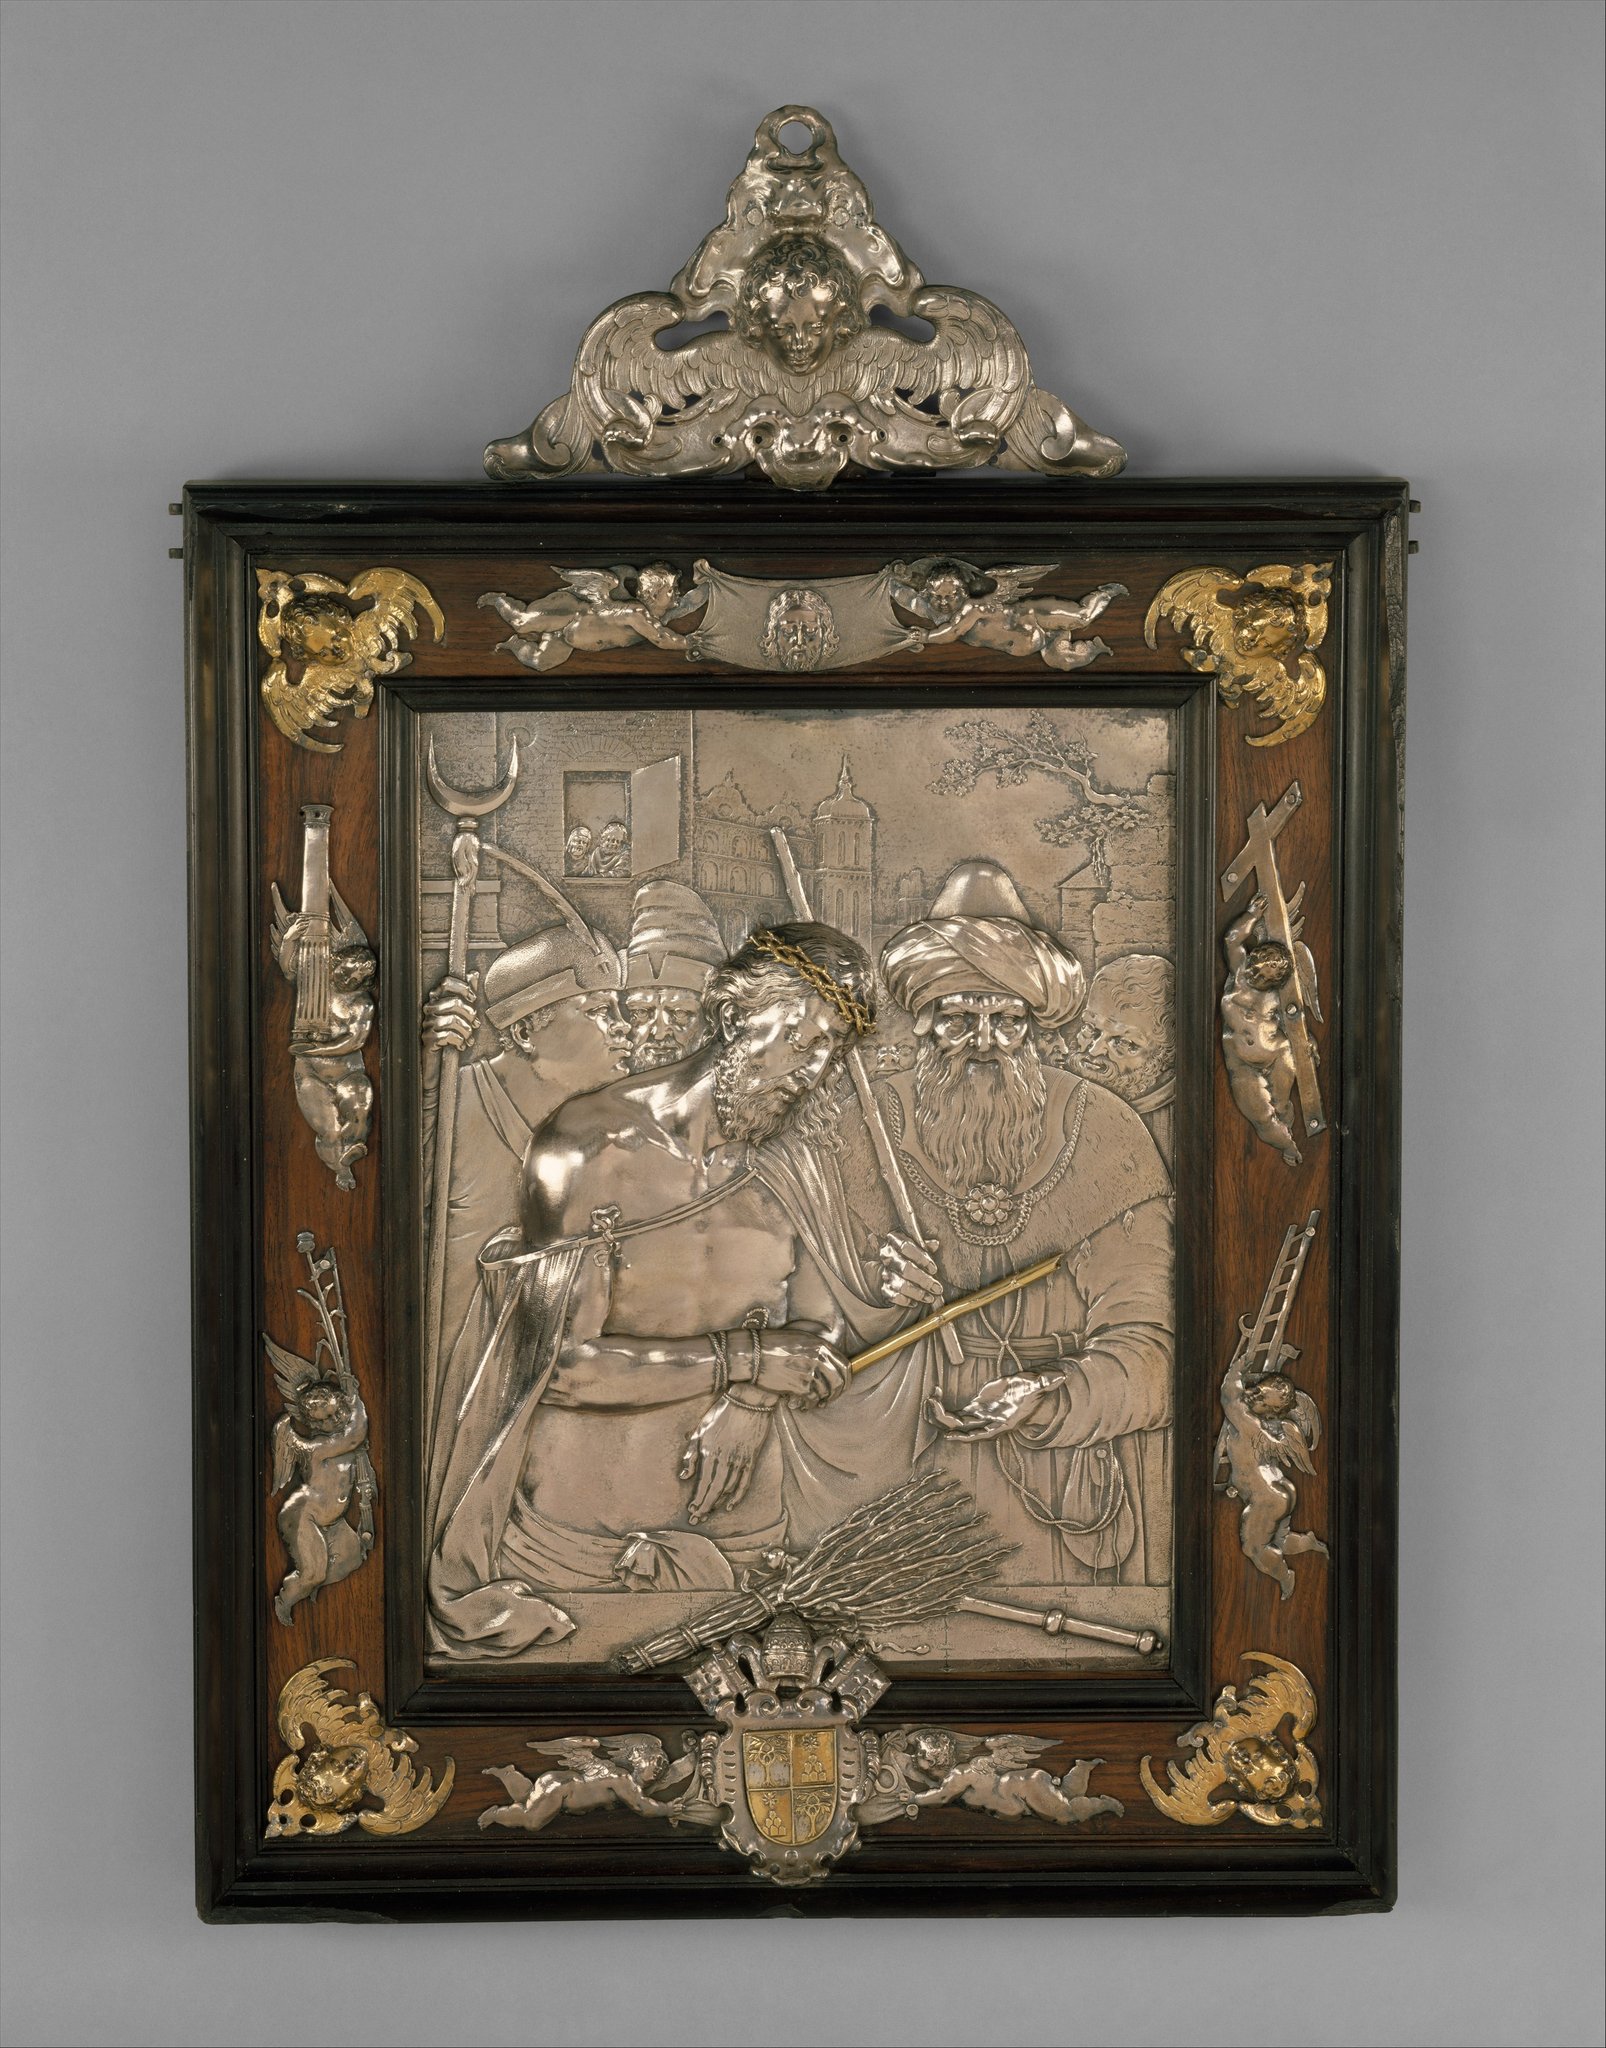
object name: plaquette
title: Ecce Homo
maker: anonymous, german, 17th century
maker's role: artist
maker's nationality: german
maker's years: 1600-1700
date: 1567-1633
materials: wood, silver, silver gilt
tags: men,angels,christ,coat of arms